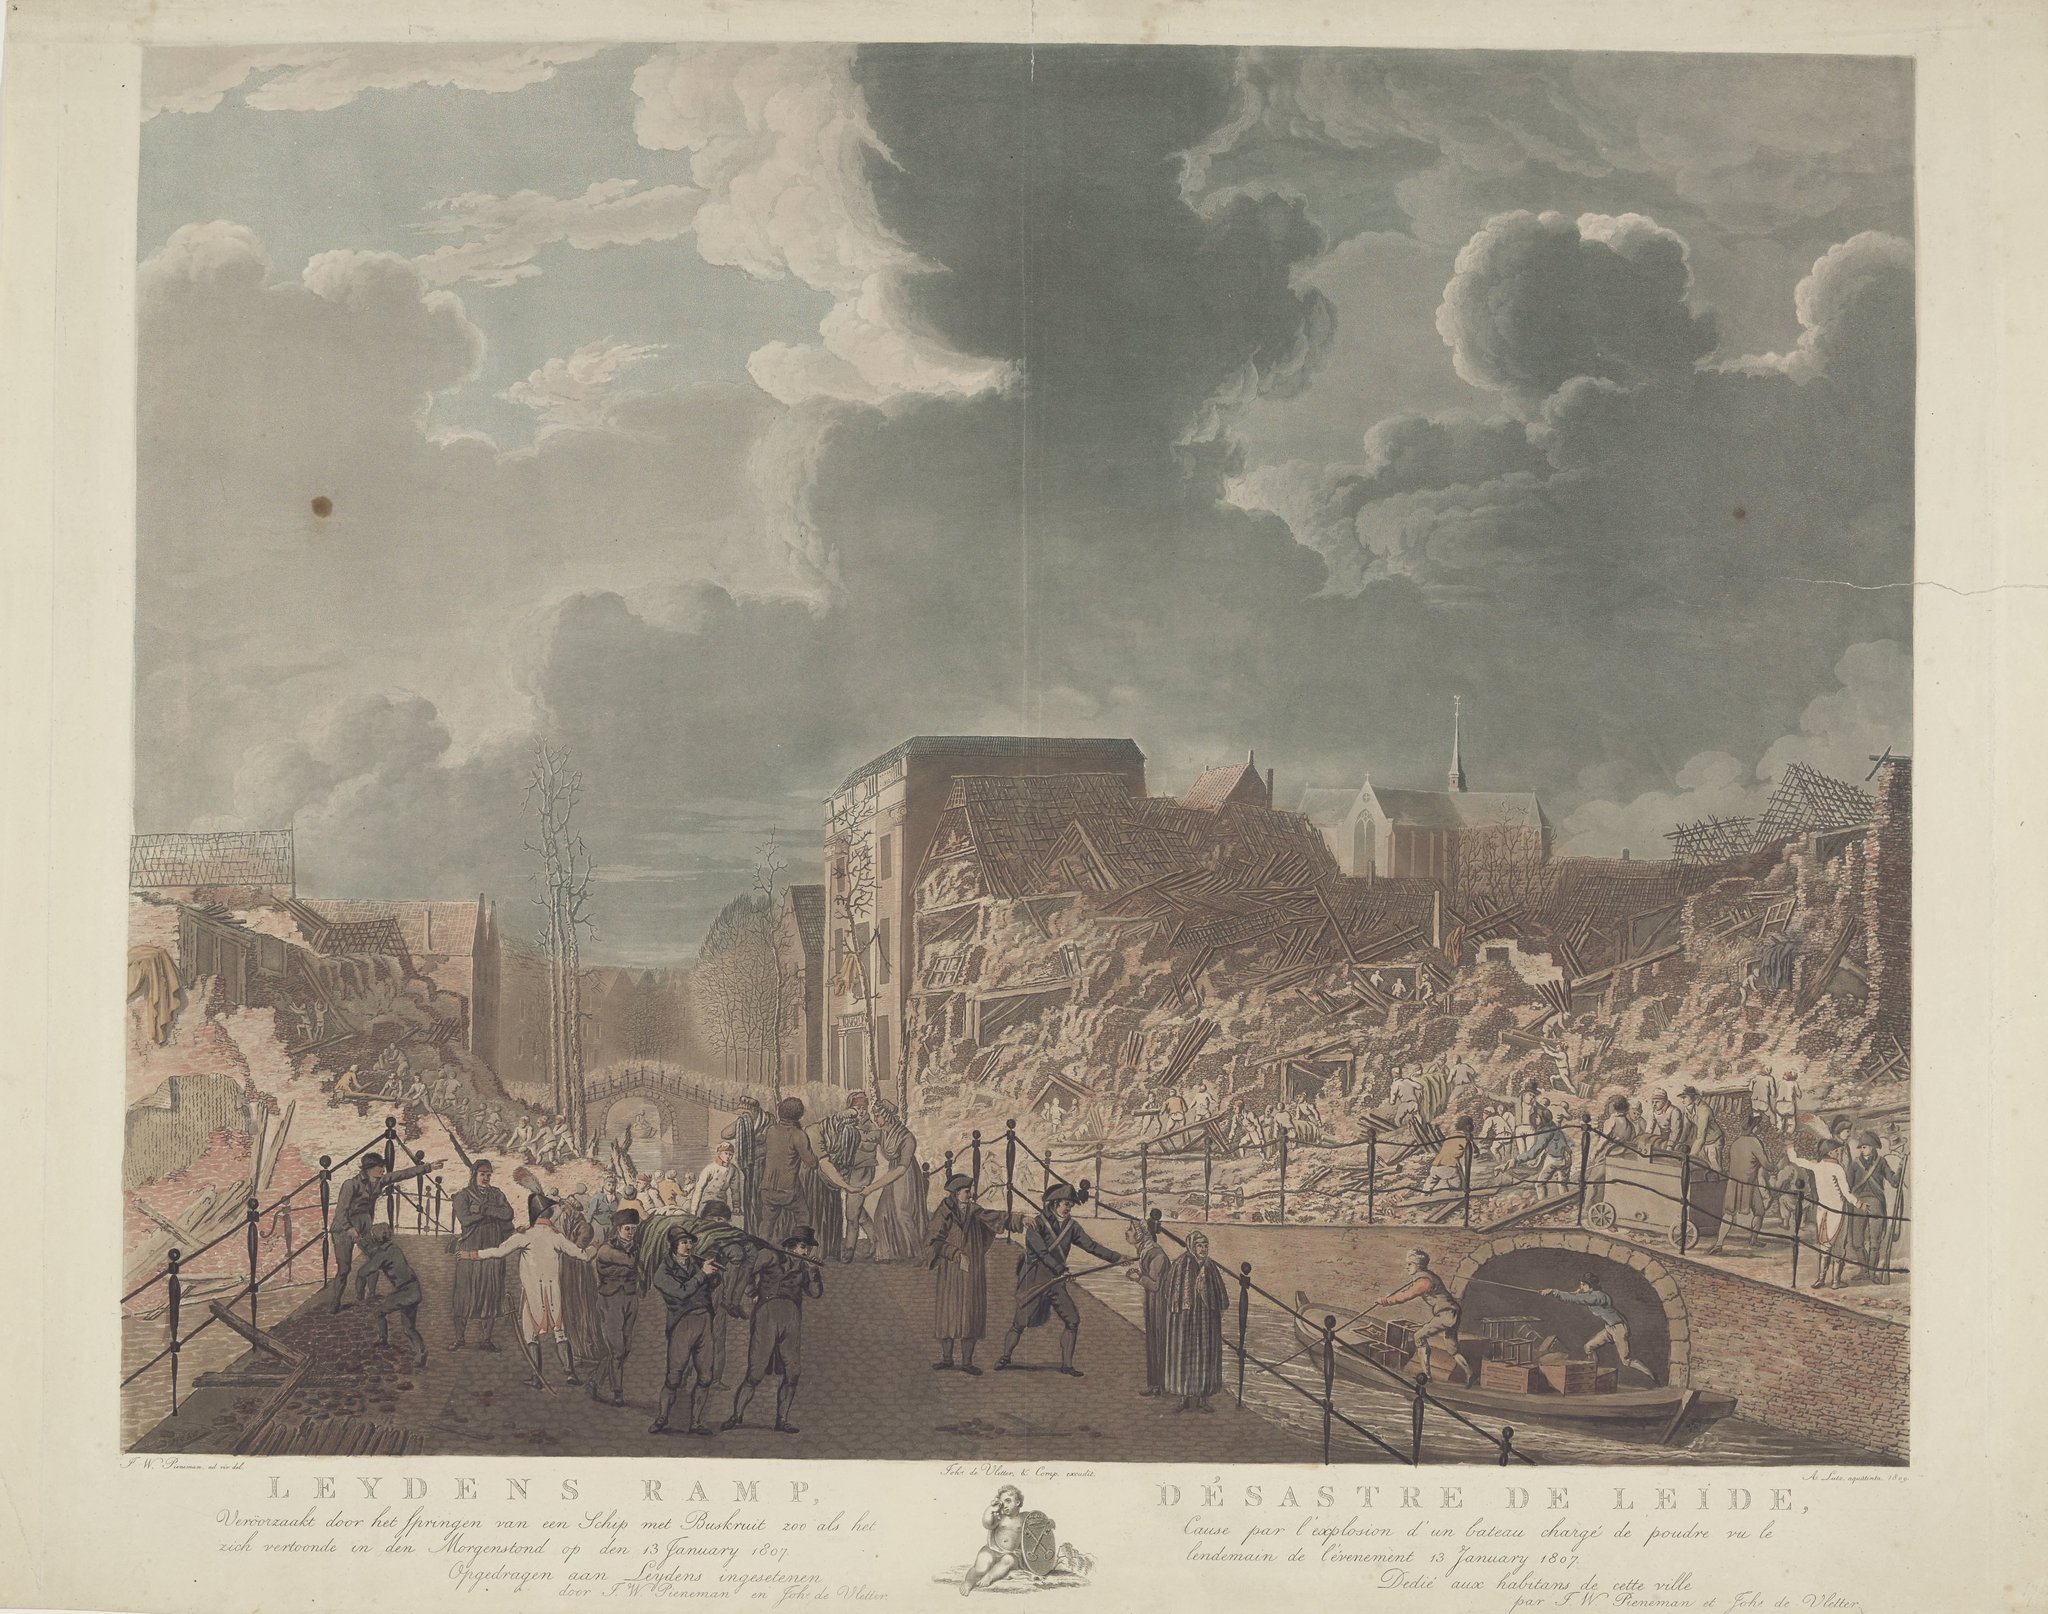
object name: print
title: Leydens Ramp, Veröorzaakt door het springen van een Schip met Buskruit zoo als het zich vertoonde in den Morgenstond op den 13 January 1807 / Désastre de Leide, Causé par l'explosion d'un bateau (...)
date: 1809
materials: paper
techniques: aquatint, etching, hand coloring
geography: netherlands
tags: gunpowder disaster, leiden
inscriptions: collector's mark: Lugt 2228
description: Gezicht op de ruïnes op het Steenschuur, een gracht in het verlengde van het Rapenburg, te Leiden na de ontploffing van het kruitschip op 12 januari 1807. Op de voorgrond wordt een slachtoffer weggedragen. Onderaan de titels in het Nederlands en Frans gescheiden door een vignet van een huilend kind met het Leidse stadswapen. Zie ook de pendant.